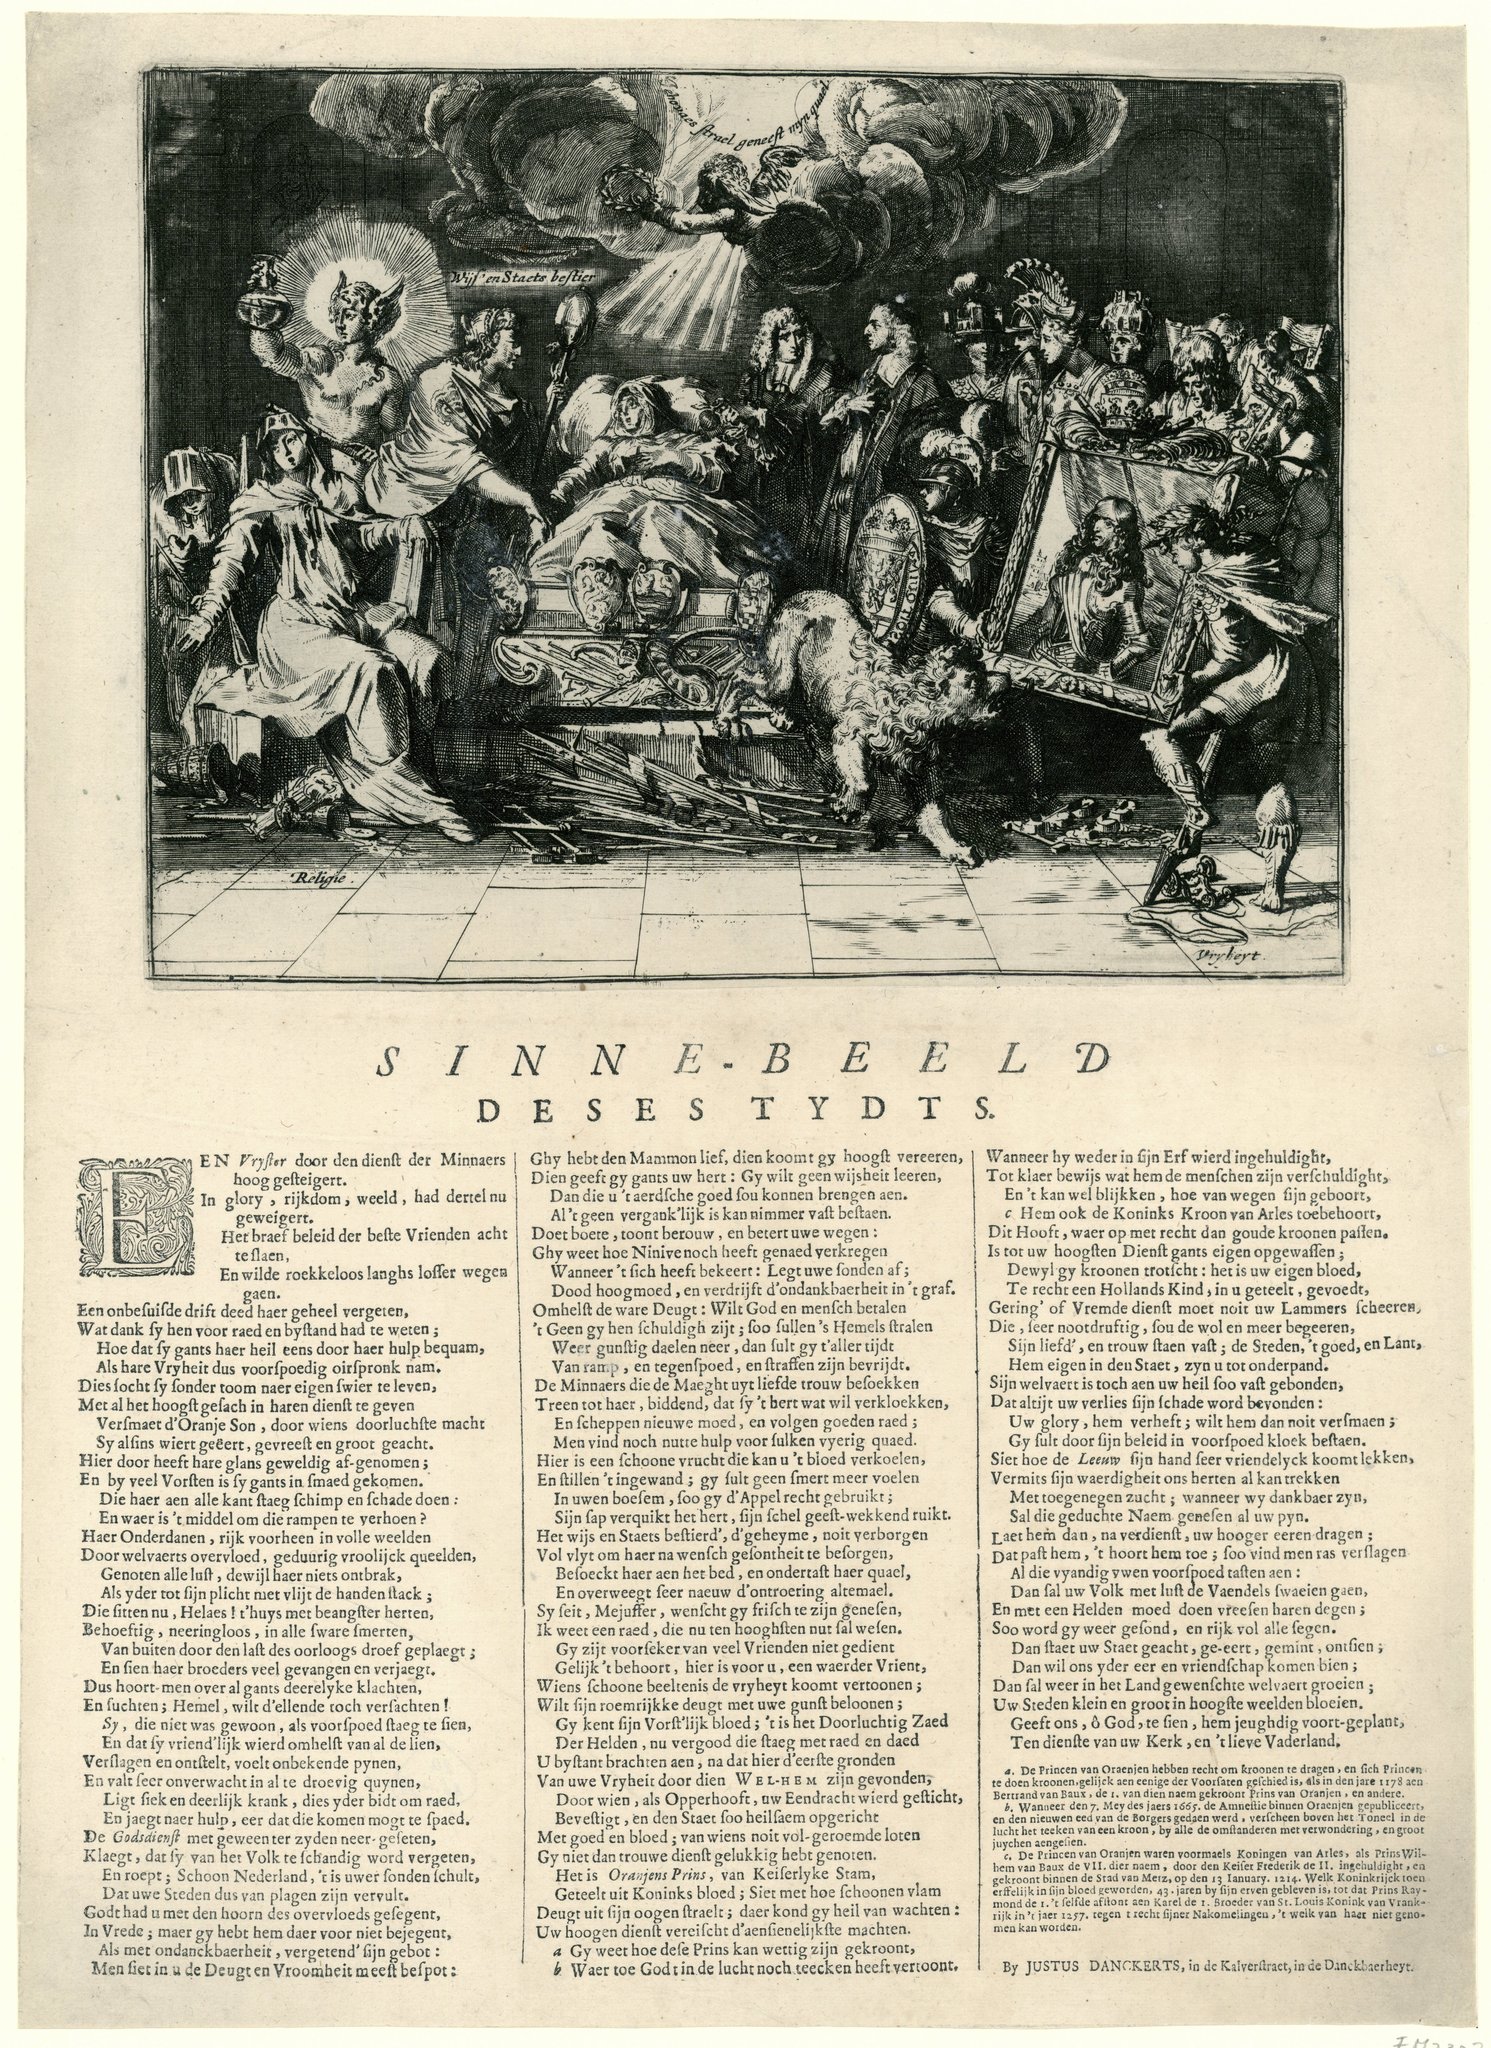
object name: print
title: Sinne-beeld deses tydts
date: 1672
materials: paper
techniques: etching, letterpress printing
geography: northern netherlands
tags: the hague, william iii (prince of orange and king of england, scotland, and ireland), personifications of countries, nations, states, districts, etc., allegorical representations ~ religion; 'religione', 'religione de ss. mauritio e lazaro', 'religione vera christiana' (ripa), patient, sick person, netherlands, rampjaar (disaster year)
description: Allegorie op de politieke situatie in het jaar 1672. Voorstelling met de Nederlandse Maagd die ziek in bed ligt. Nu de eenheid van de zeven provincies verbroken is, keert de Nederlandse leeuw zich naar het portret van Willem III. Rond het bed verschillende regenten en allegorische figuren, waaronder Religie en Vrijheid. Onder de voorstelling een Nederlandse vers in 3 kolommen die grotendeels overeen komt met het vers onder de oorspronkelijke plaat van De Passe uit 1665.